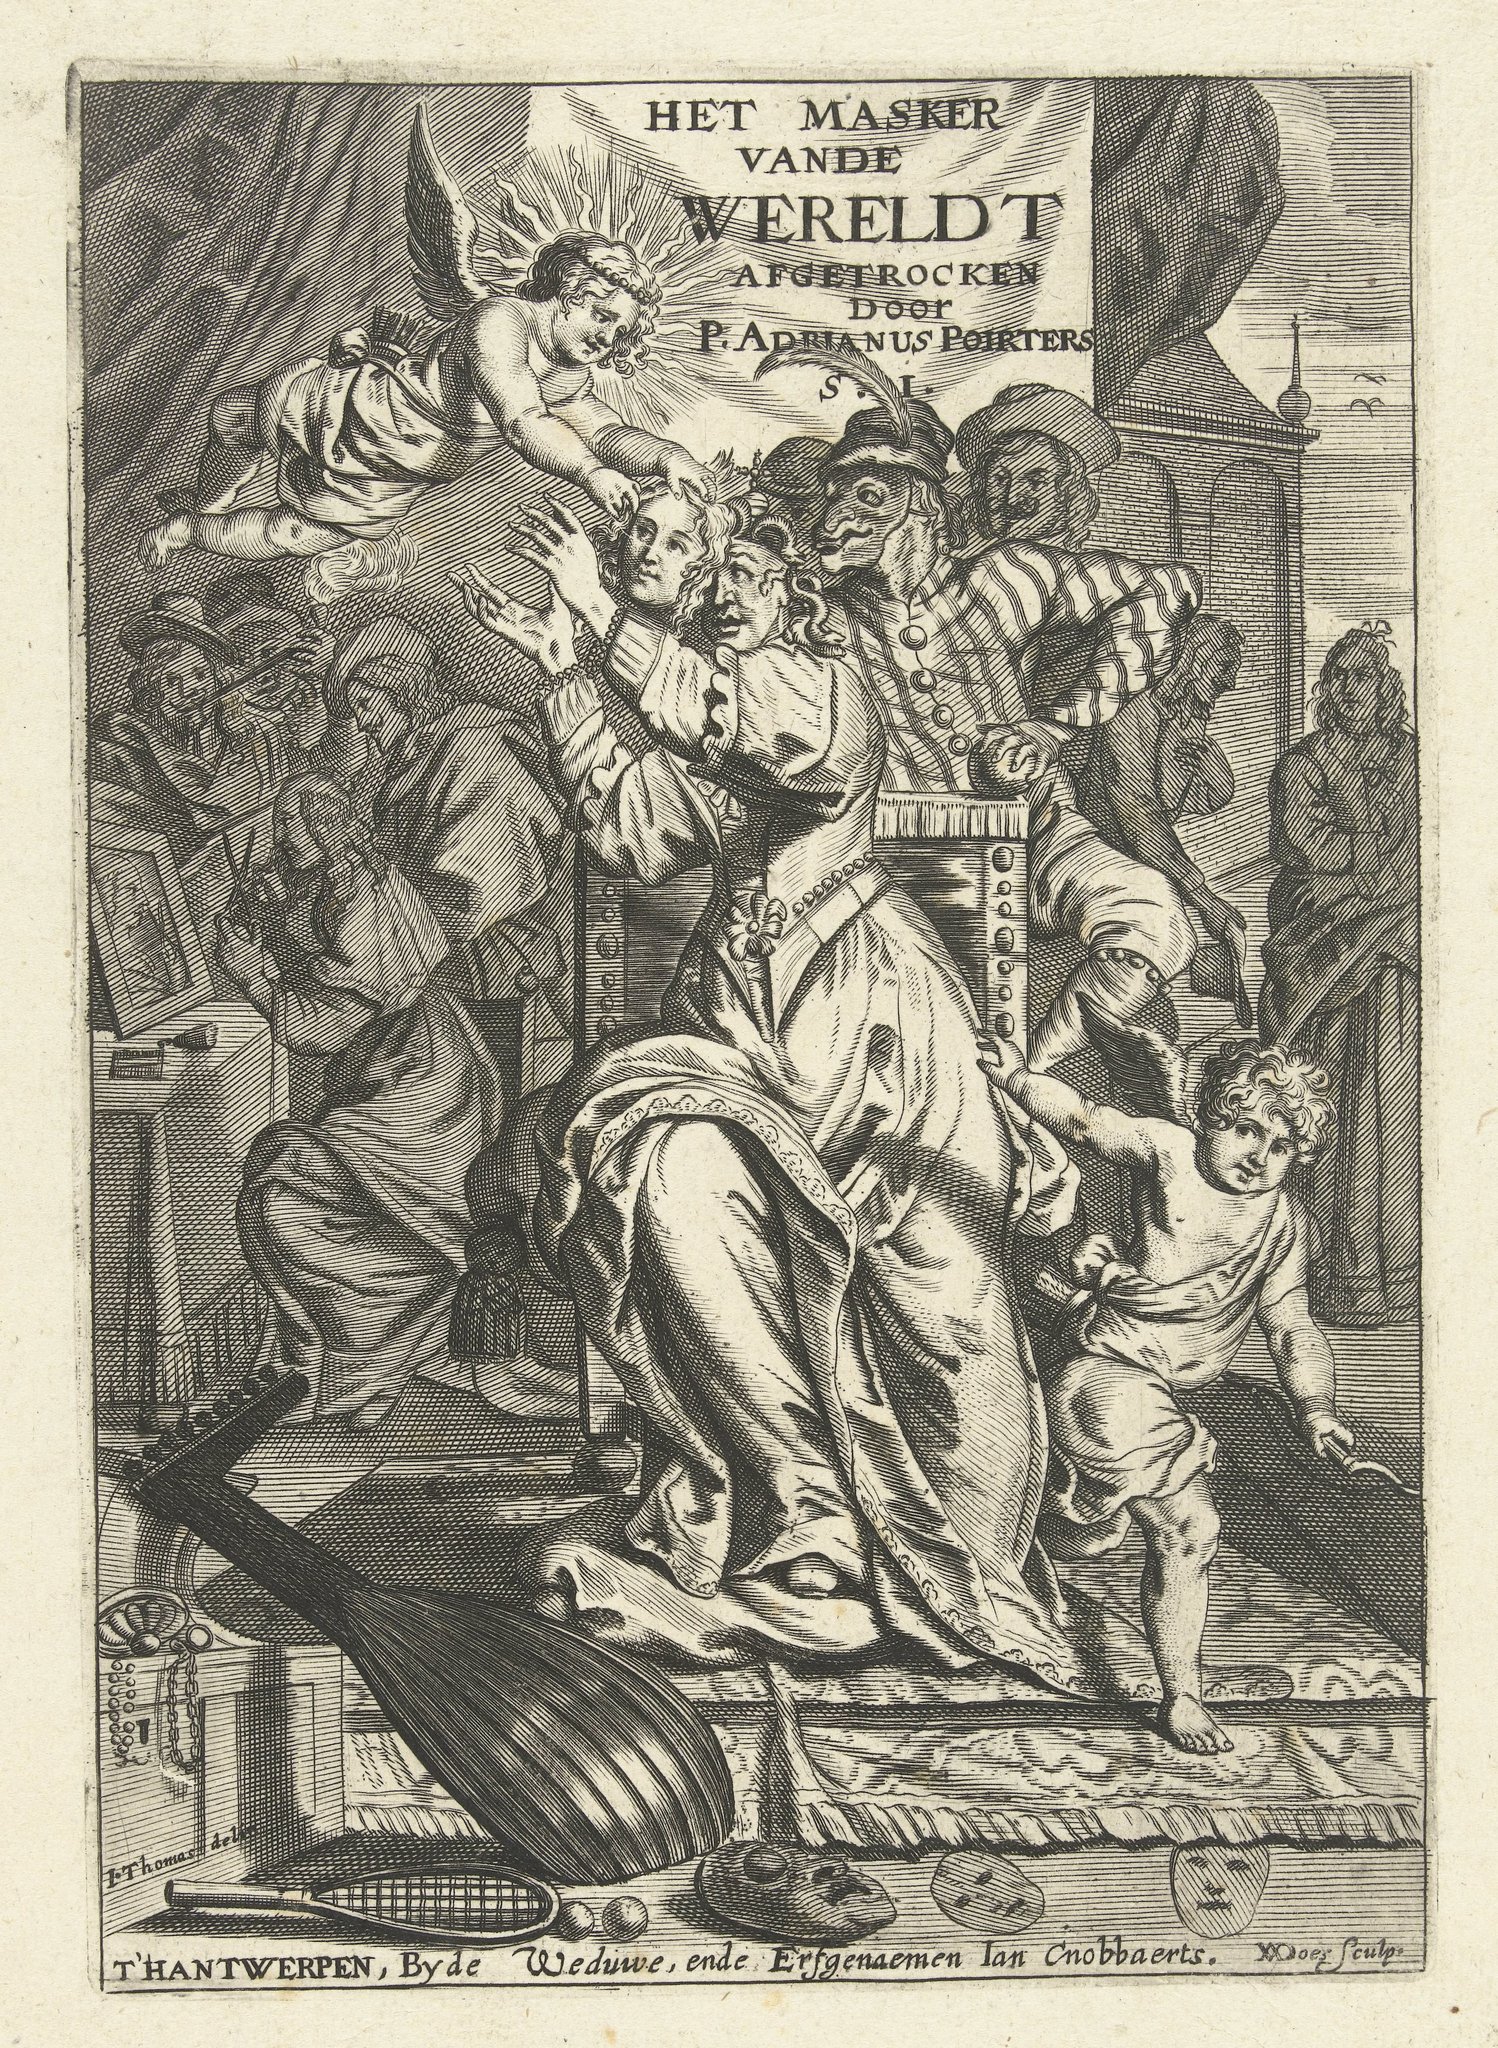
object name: titelprent, frontispice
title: Vrouw ontmaskerd door engel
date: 1645-1680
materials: paper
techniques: engraving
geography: southern netherlands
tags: pantomime, dumb show, masque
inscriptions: collector's mark: Lugt 240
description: Titelprent voor: Adrianus Poirters, Het masker vande wereldt afgetrocken, Antwerpen, wed. ende erfg. I. Cnobbaerts, niet voor 1645